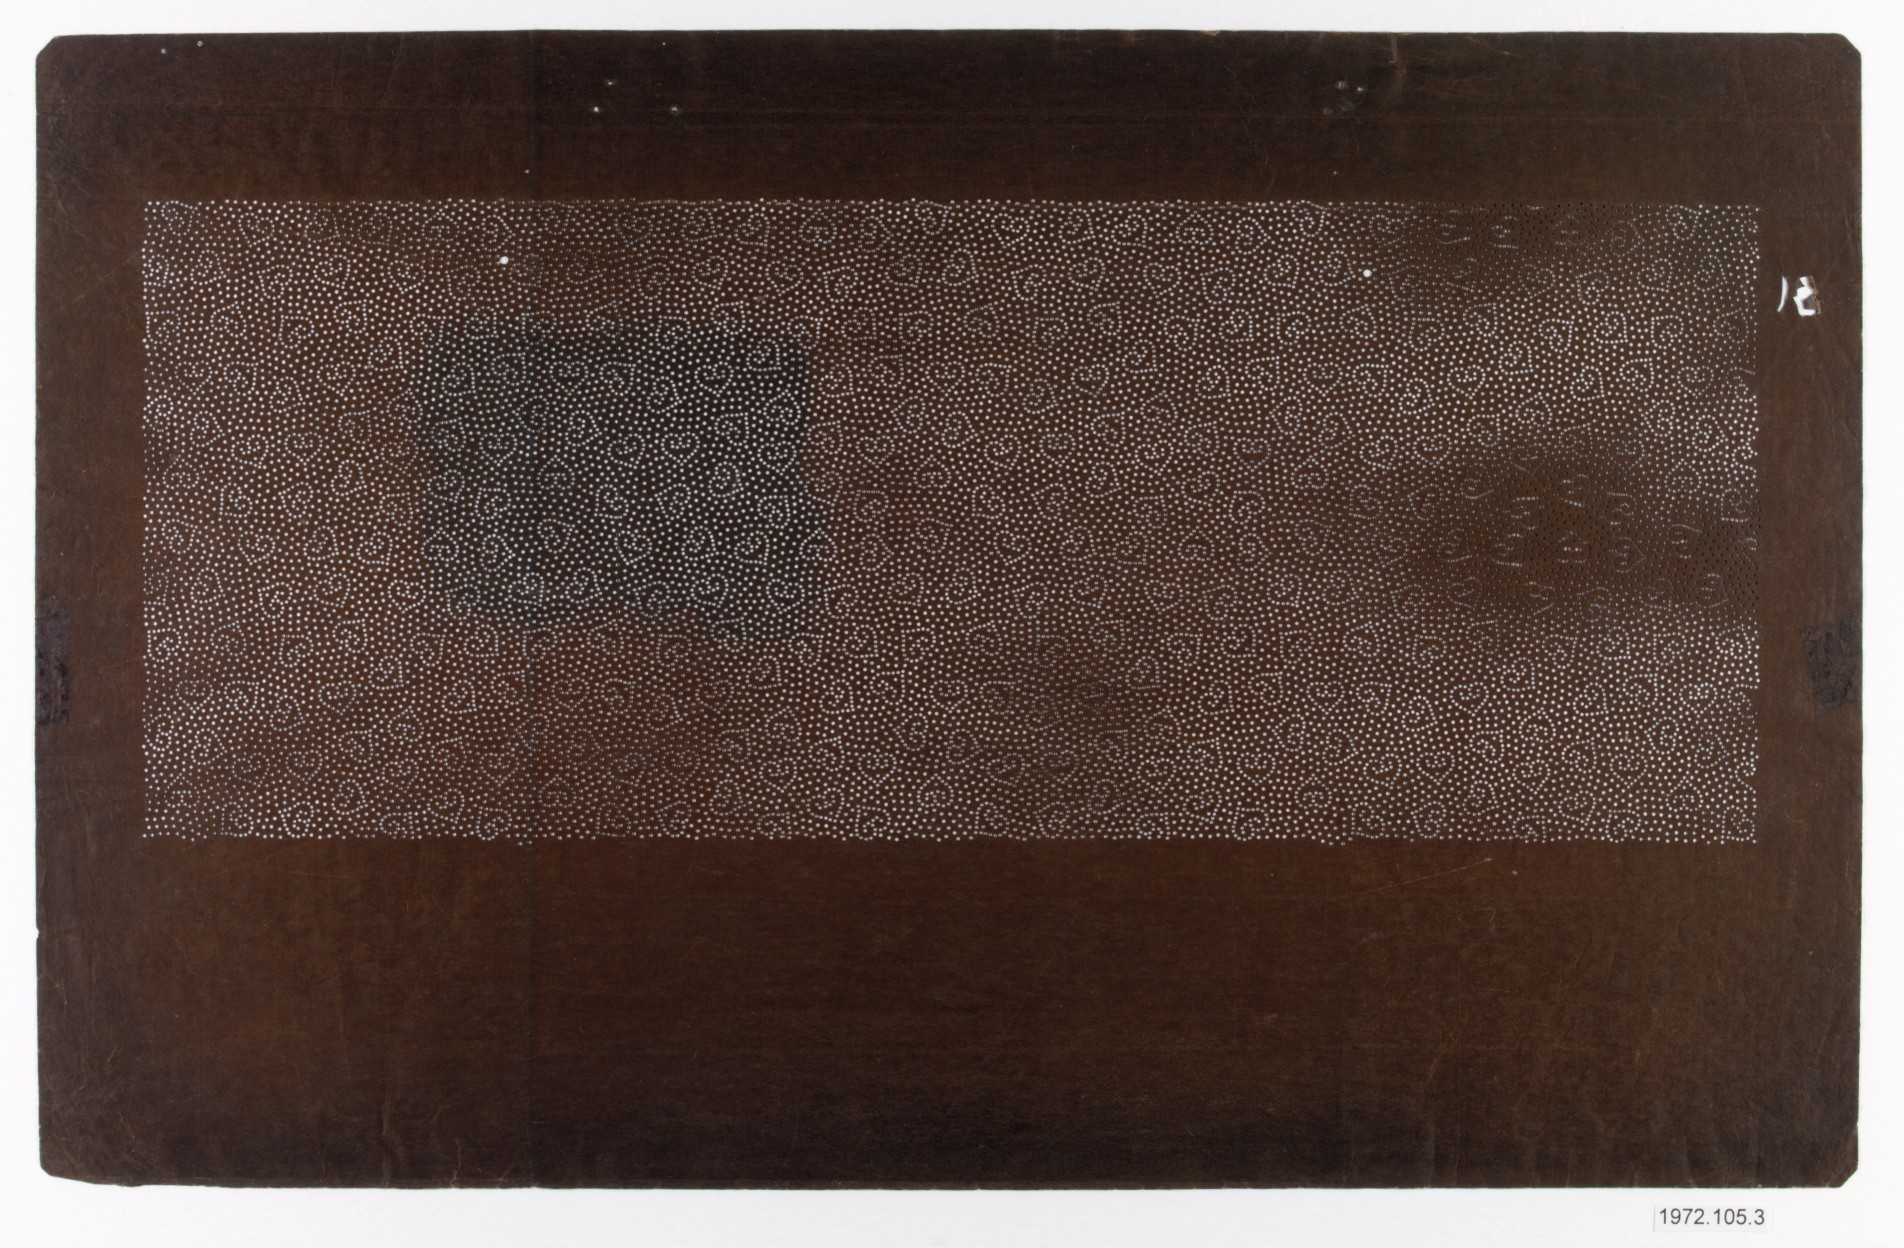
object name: stencil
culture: japanese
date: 1701-1900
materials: paper